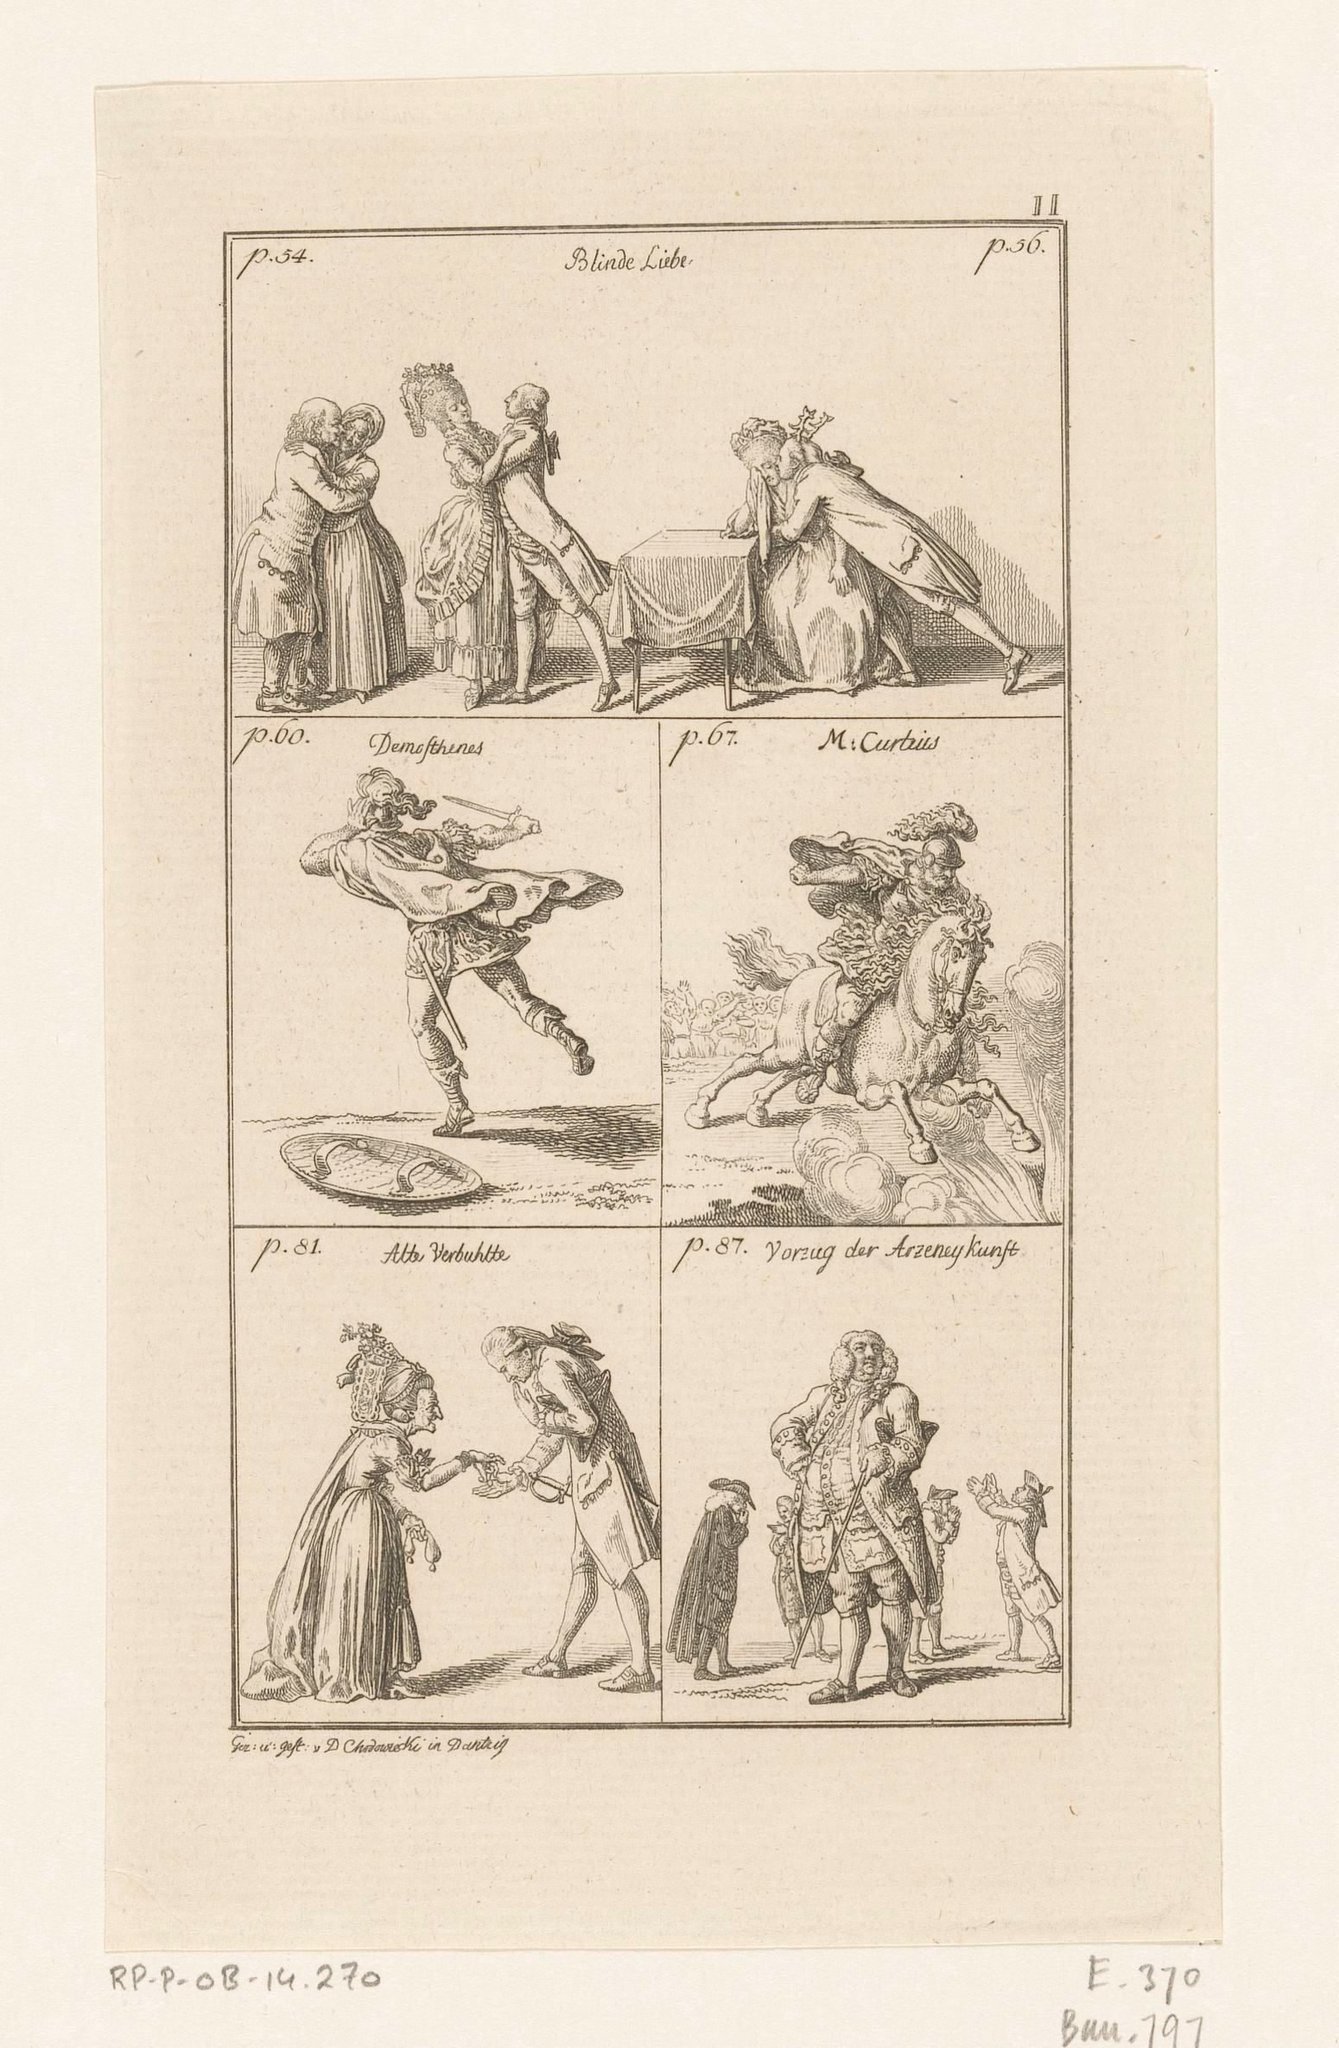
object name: print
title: Blad uit De Lof der Zotheid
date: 1780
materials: paper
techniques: etching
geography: gdansk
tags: rotterdam, desiderius erasmus, (story of) marcus (manlius) curtius, physician, doctor, ugly old woman, hag, (story of) demosthenes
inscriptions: collector's mark: Lugt 2228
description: Blad met vijf omkaderde illustraties, elk behorend tot een apart tekstdeel. Afgebeeld zijn: de blinde liefde, Demosthenes, Marcus Curtius, de oude vrouw en de geneeskunst. Rechtsboven genummerd: II.